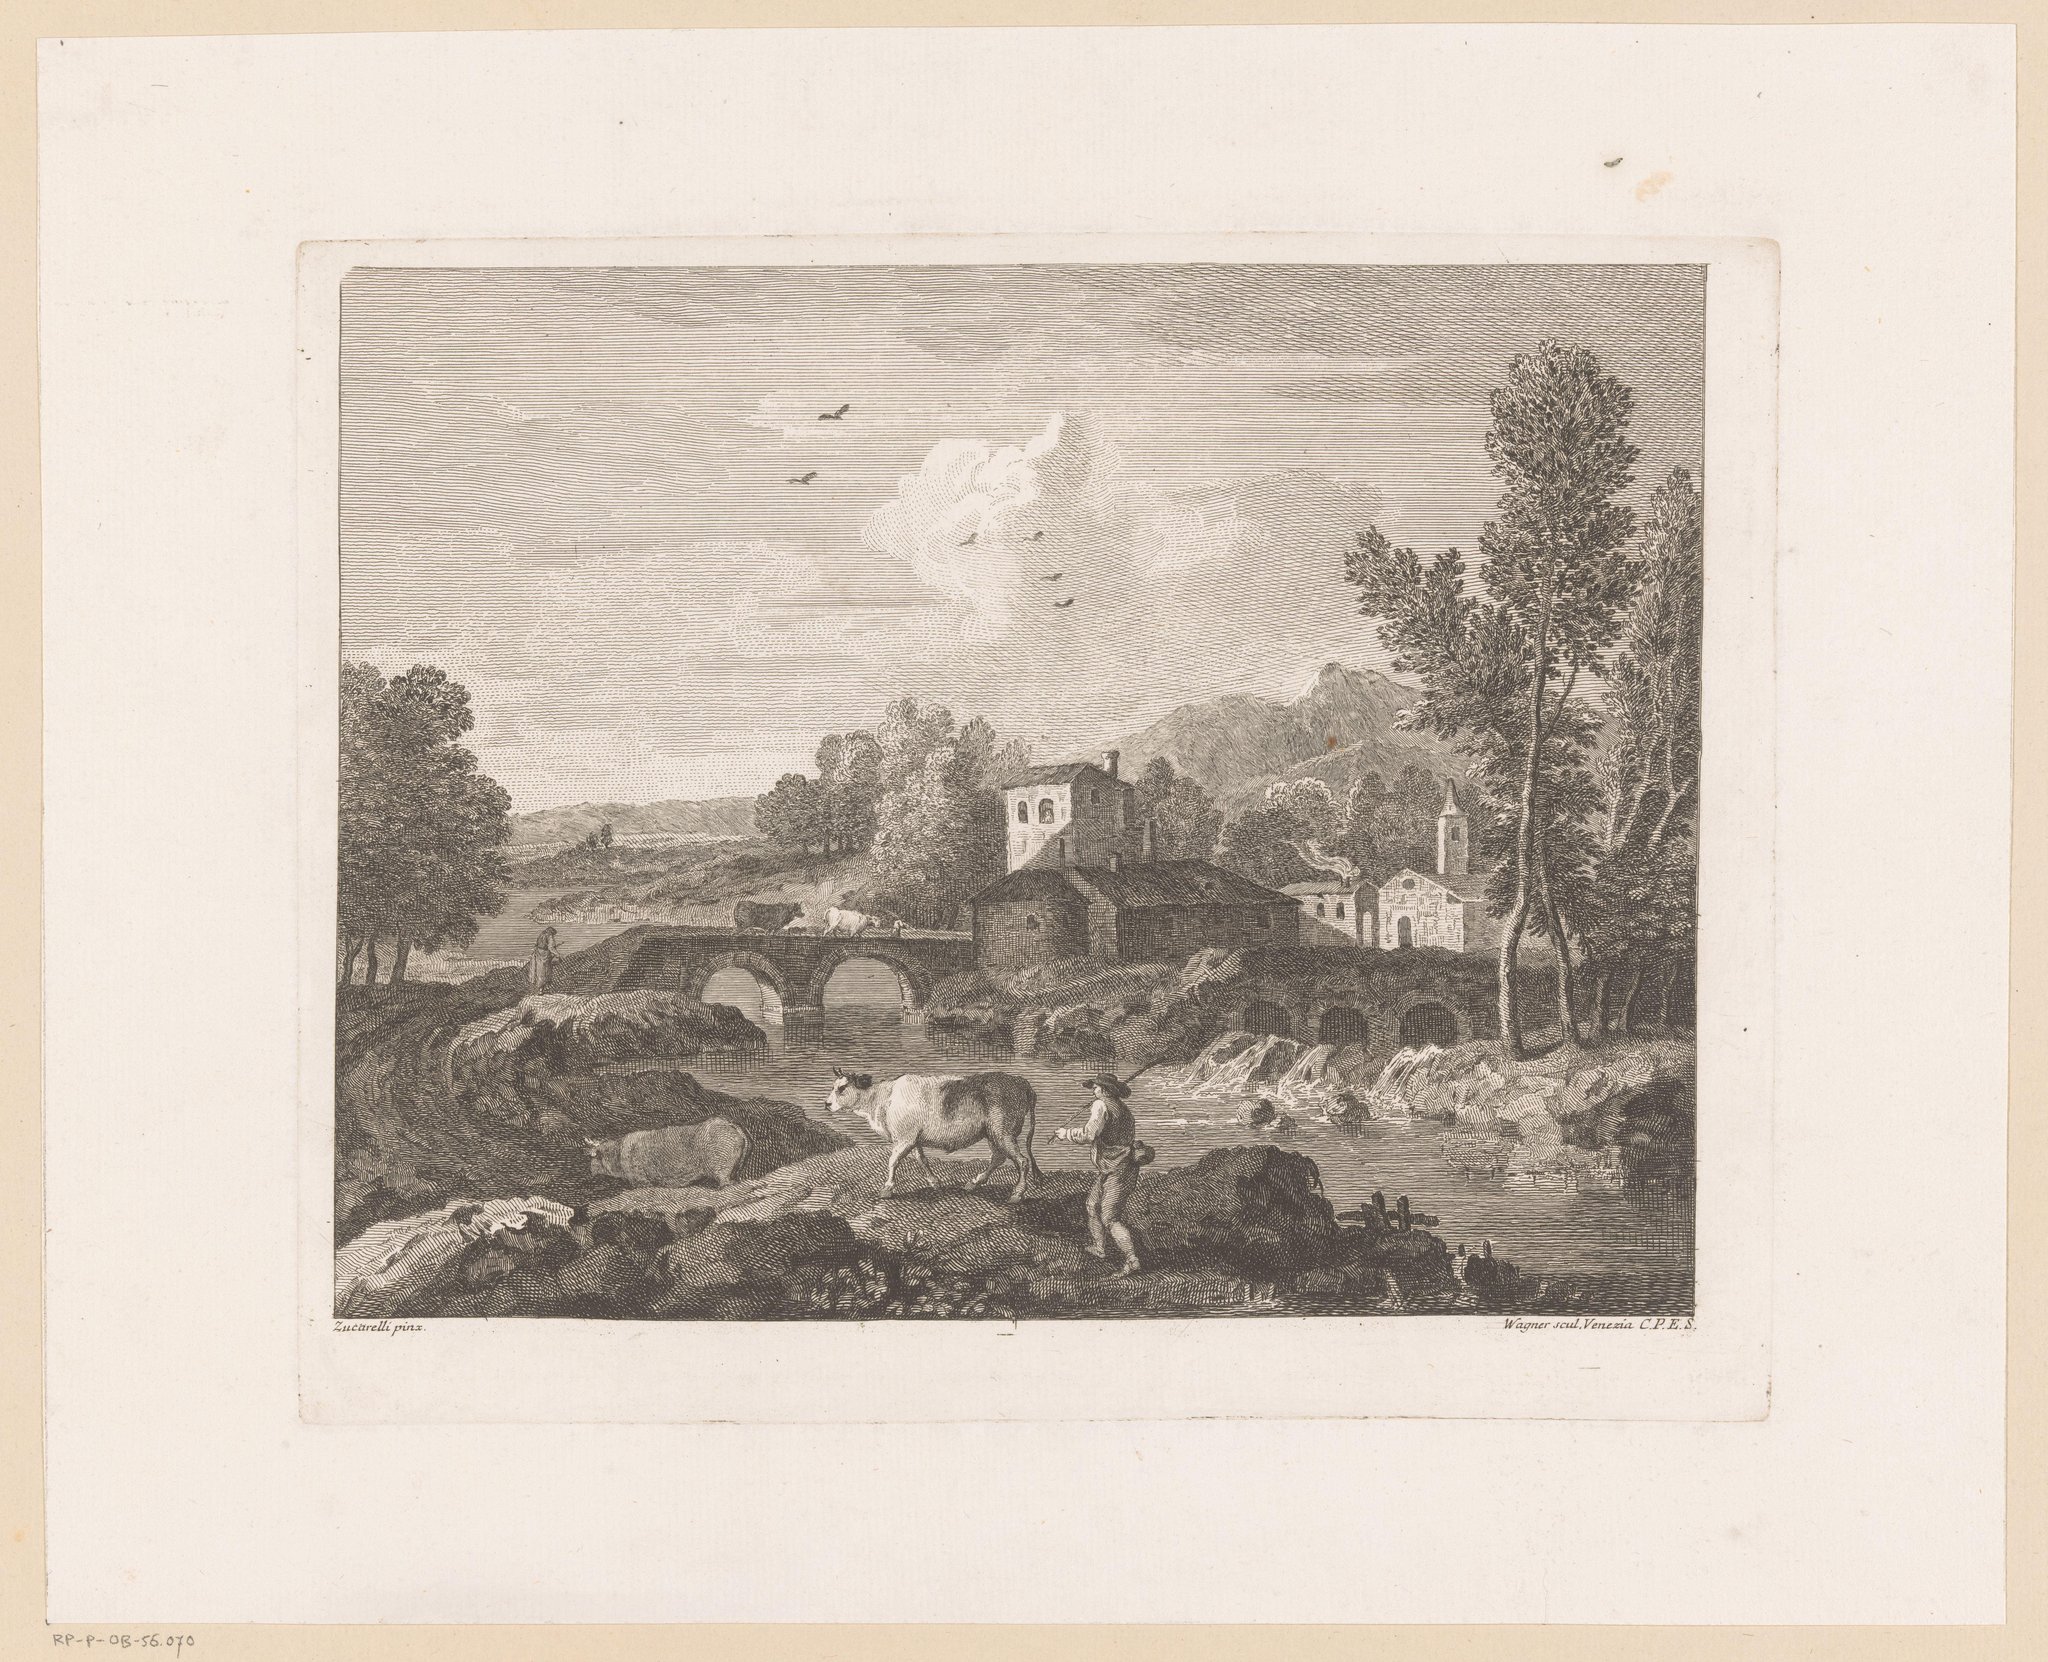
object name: print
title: Rivierlandschap met herder en koeien op brug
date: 1739-1780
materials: paper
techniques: engraving, etching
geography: venice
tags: cow, river, herding, herdsman, herdswoman, shepherd, shepherdess, cowherd, etc., landscape with bridge, viaduct or aqueduct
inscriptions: collector's mark: Lugt 240